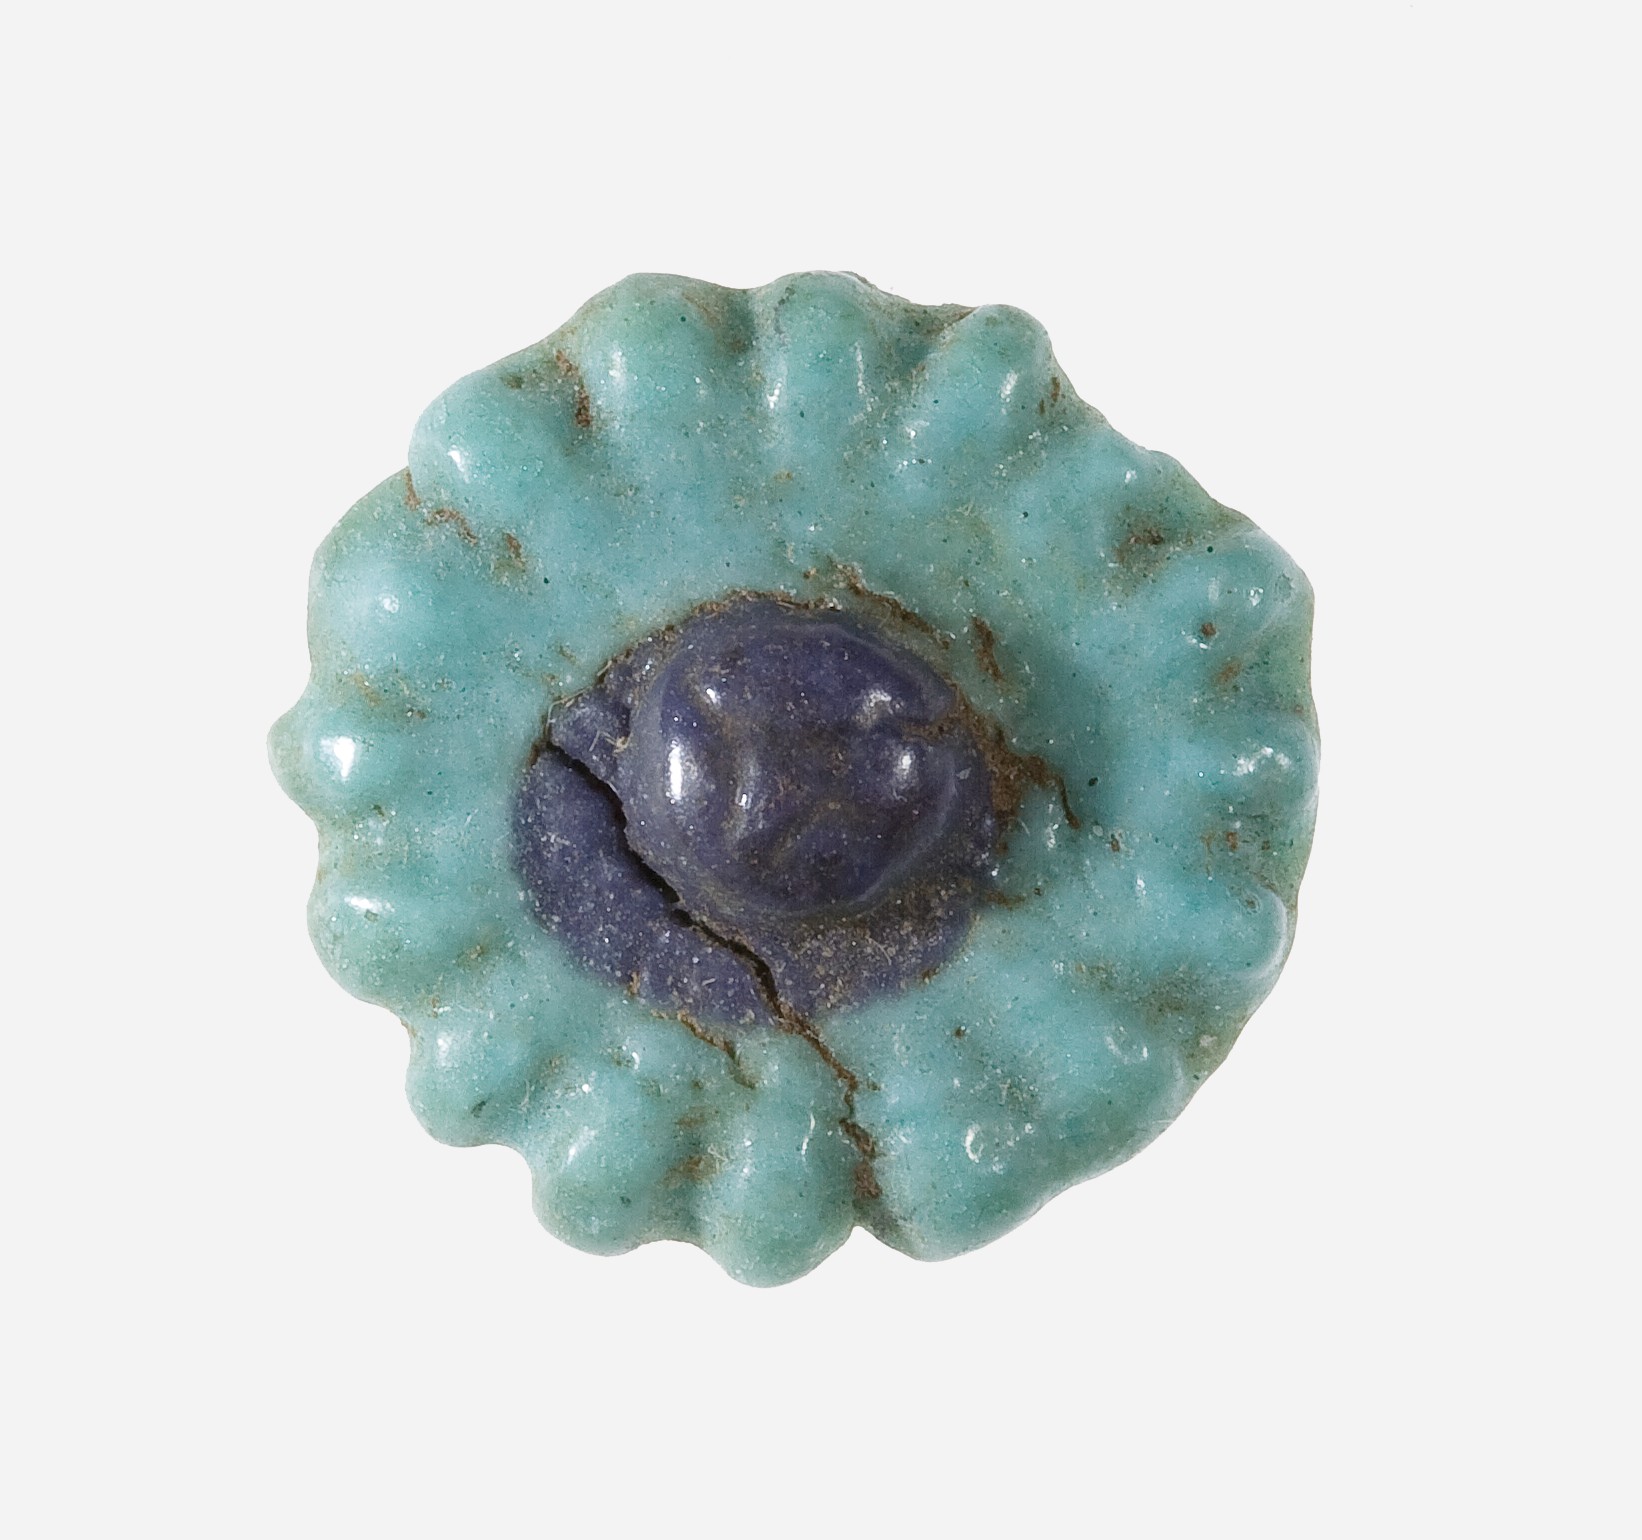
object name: bead, daisy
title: Daisy Bead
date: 1390-1352 BCE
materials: faience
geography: egypt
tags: daisies